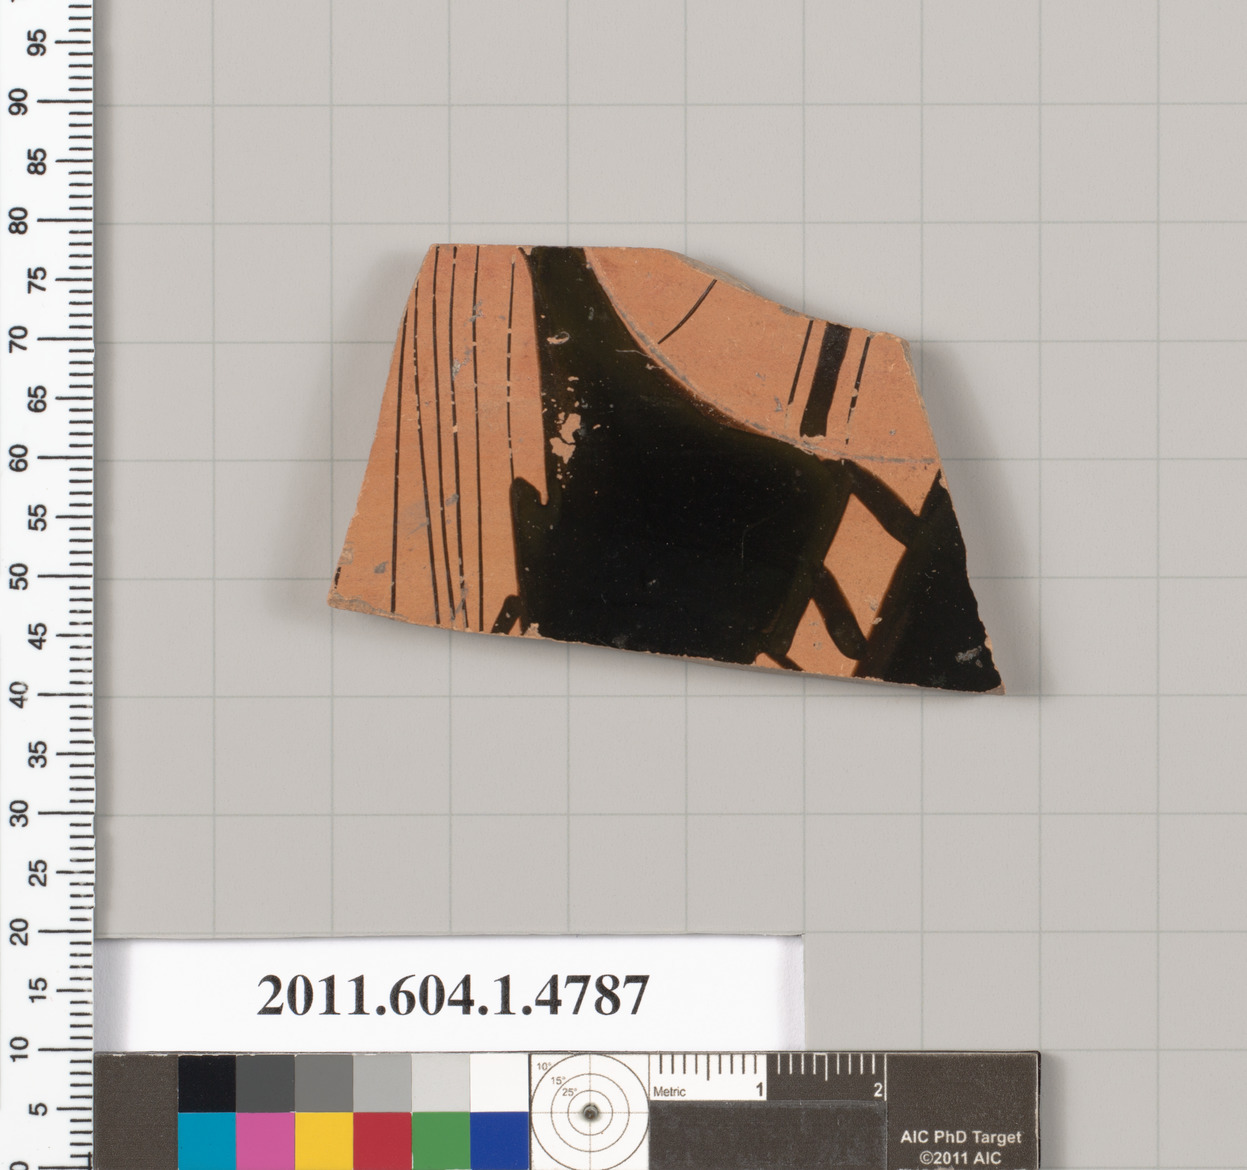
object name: kylix fragment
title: Terracotta fragment of a kylix (drinking cup)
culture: greek, attic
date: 475-451 BCE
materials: terracotta